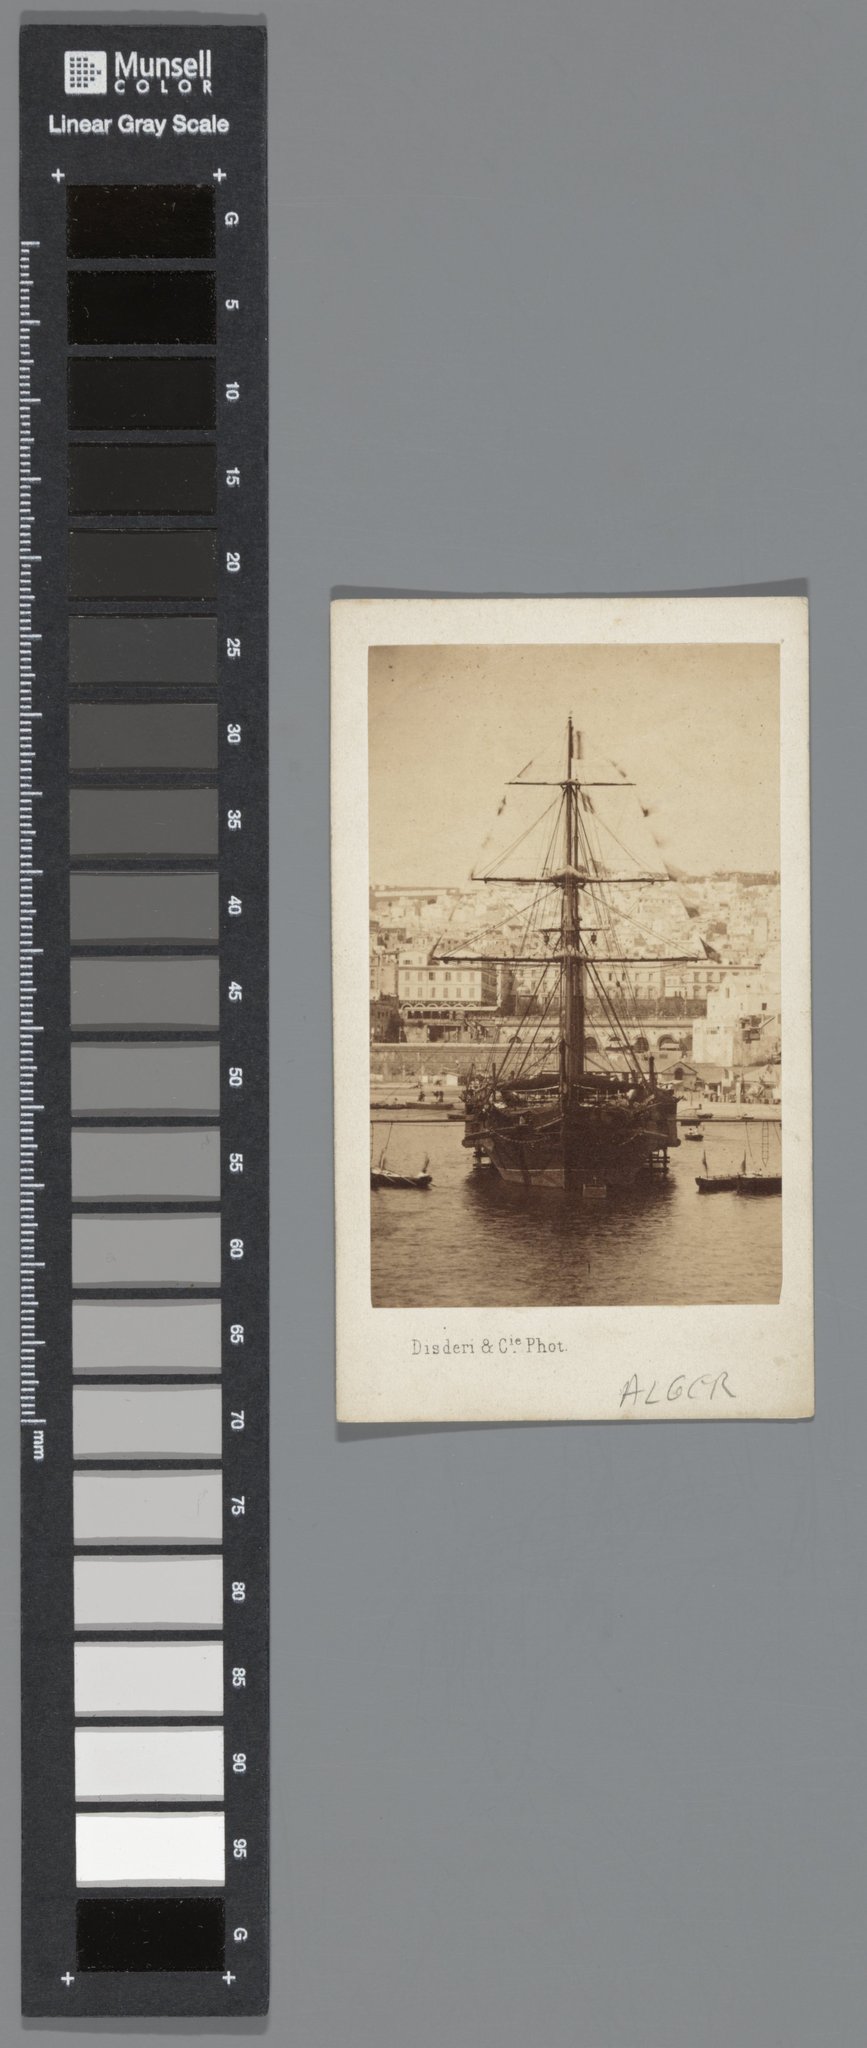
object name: carte de visite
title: Schip in de haven van Algiers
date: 1855-1860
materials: cardboard, paper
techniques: albumen print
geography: algiers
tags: harbour, sailing-ship, sailing-boat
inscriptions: inscription: ‘Alger’, inscription: ‘Disderi & Cie./ Photographes de S.M. l'Empereur/ 8, Boulevard des Italiens/ Paris’, inscription: ‘Disderi & Cie. Phot.’, inscription: ‘176 vue d'Alger prise/ du môle de la marine’